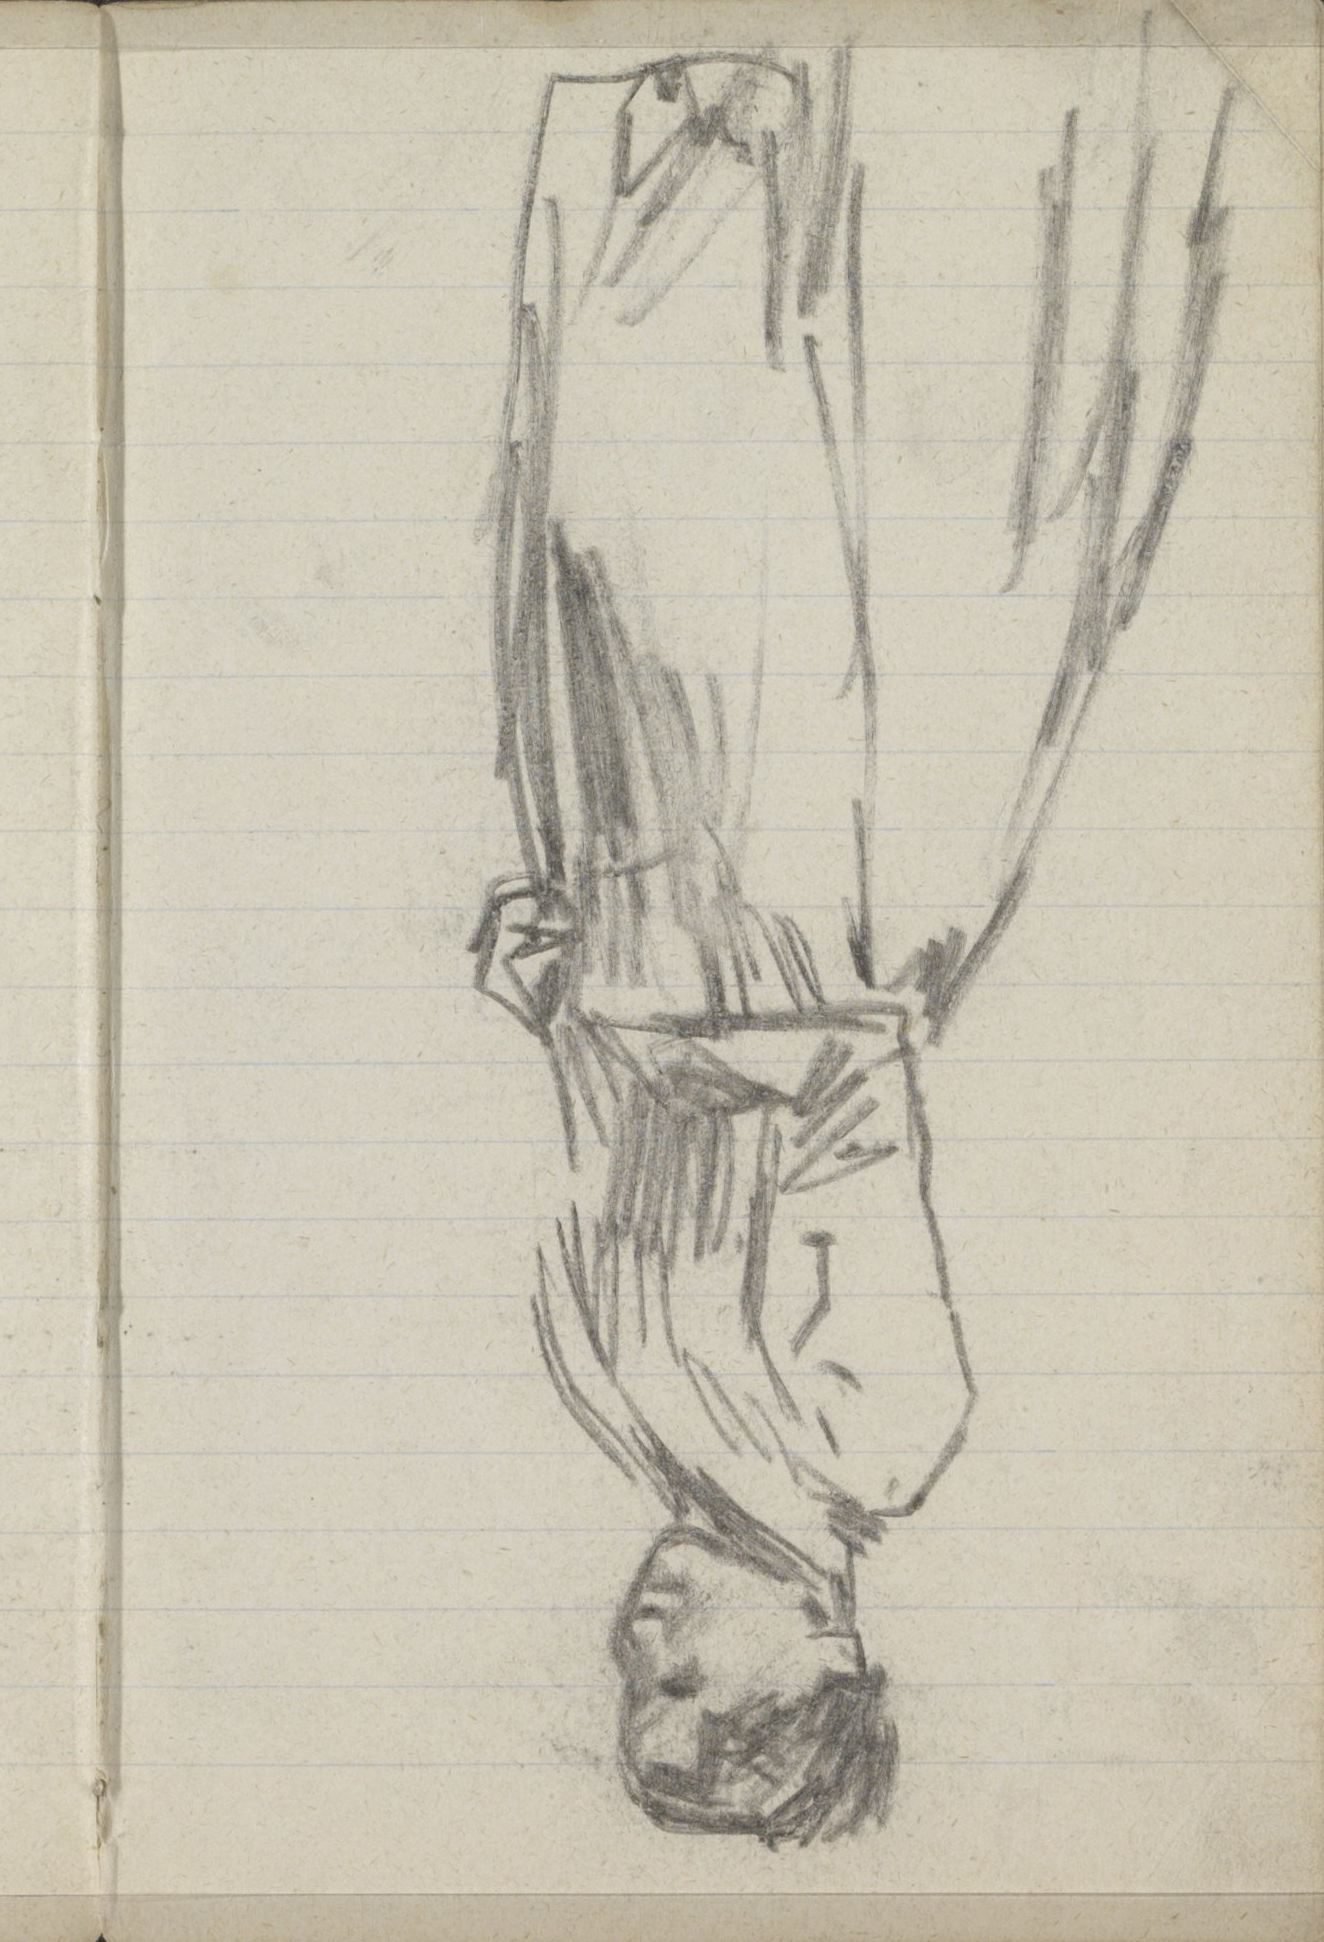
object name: sketchbook leaf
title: Staande vrouw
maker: george hendrik breitner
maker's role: draughtsman, painter, print maker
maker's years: 1857-1923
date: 1893-1898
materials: chalk, paper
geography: amsterdam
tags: adult woman, standing figure - aa - female human figure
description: Pagina 36 uit een schetsboek met 31 bladen.